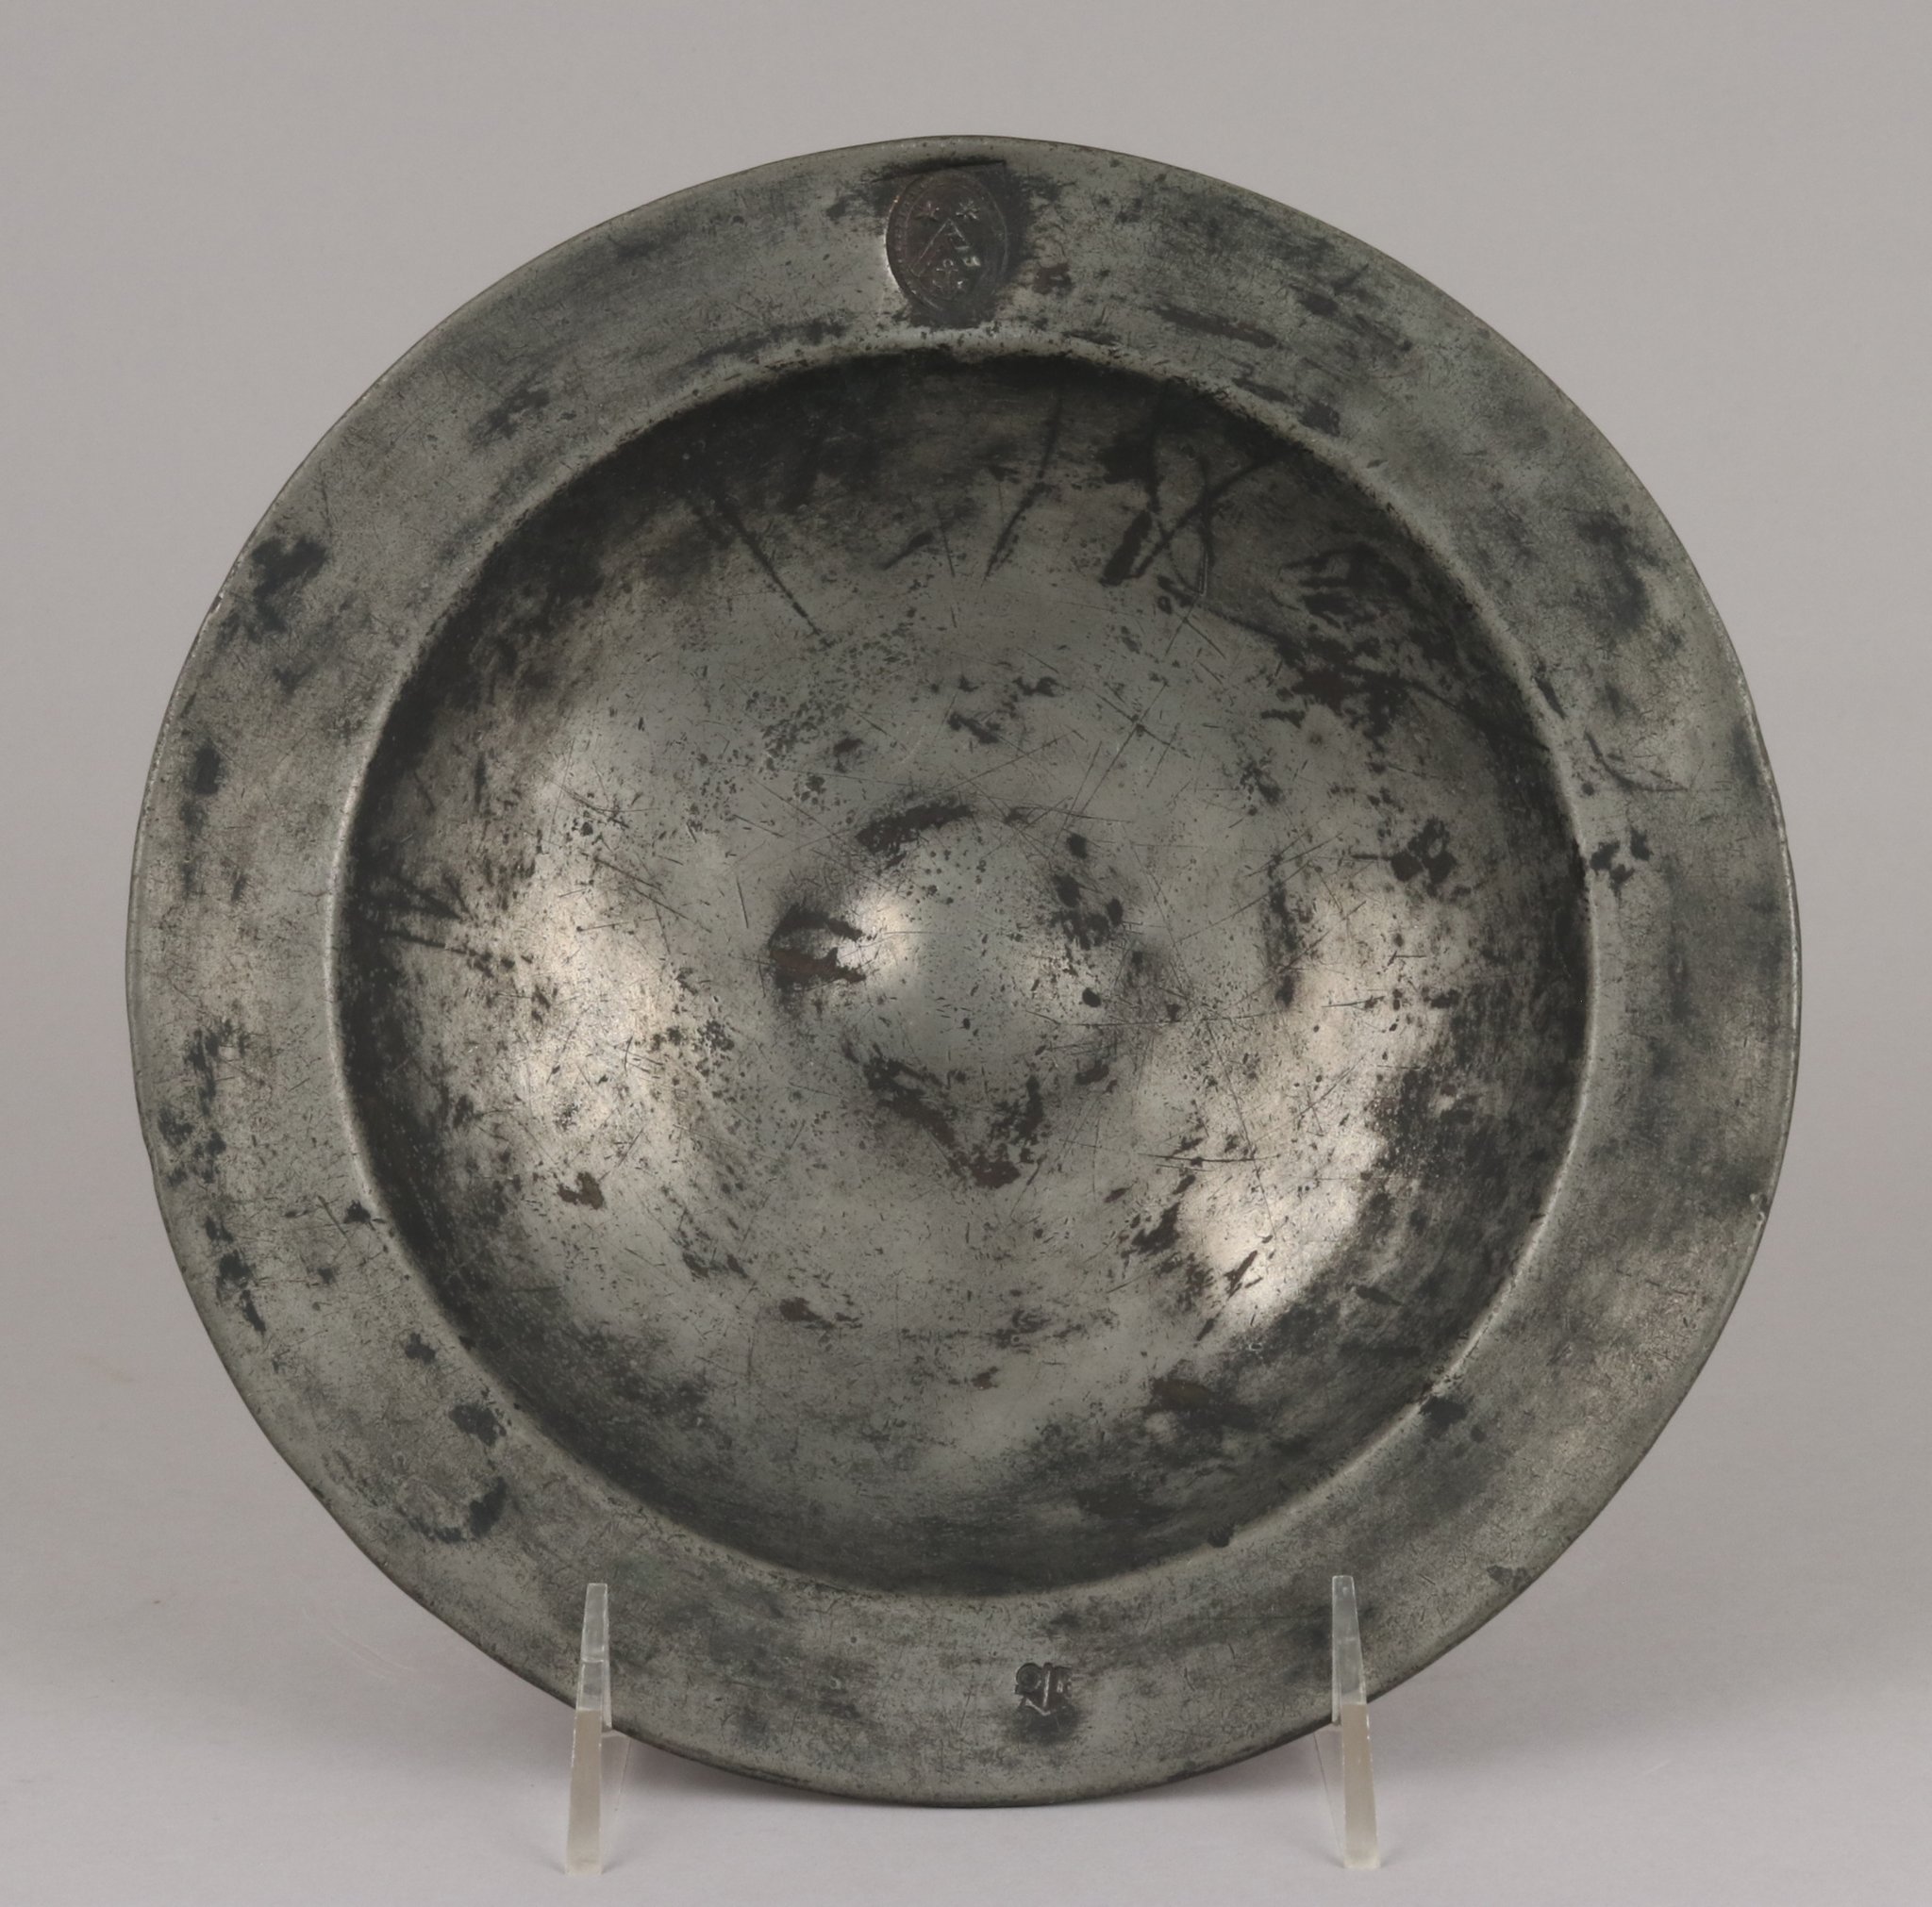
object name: plate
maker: jean golin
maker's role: maker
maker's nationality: french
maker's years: 1550-1650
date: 1601-1633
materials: pewter